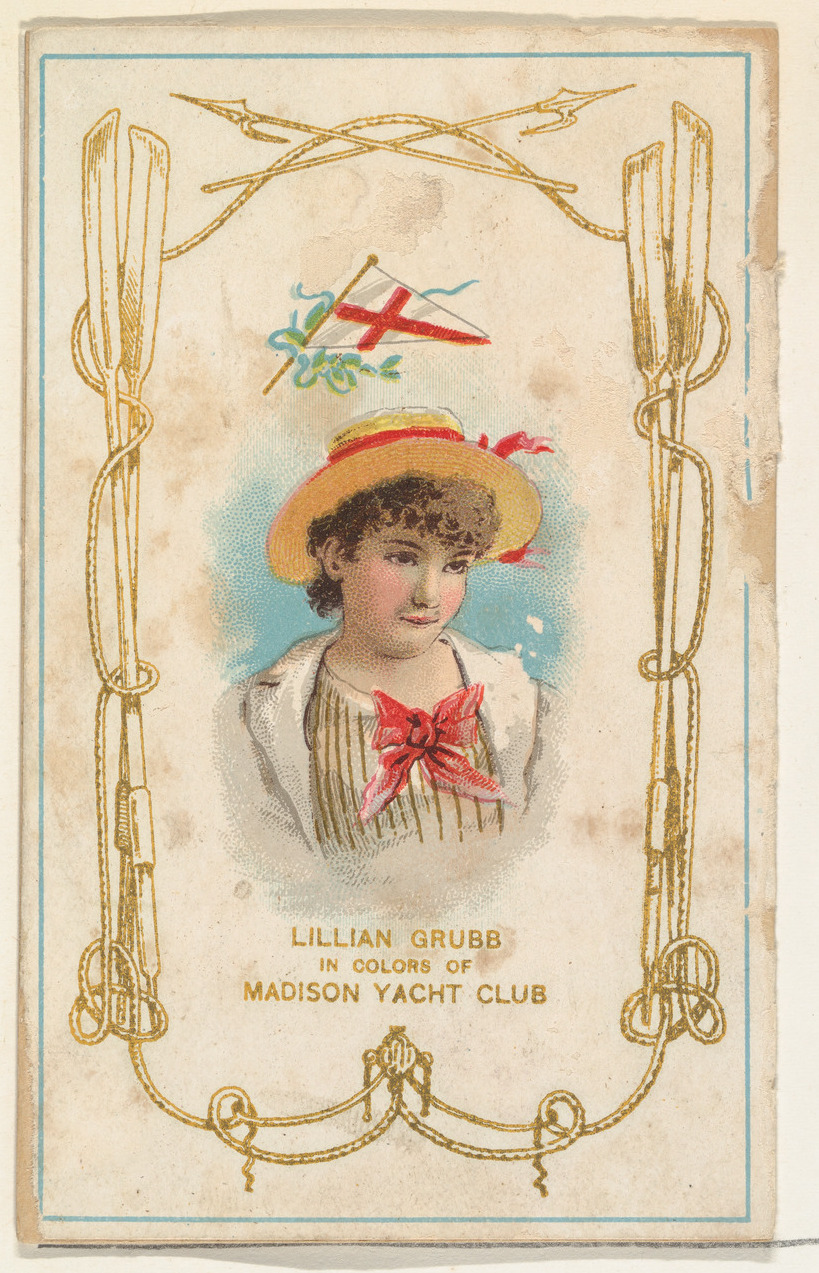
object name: print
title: Lillian Grubb in the Colors of the Madison Yacht Club, from the Yacht Colors of the World series (N140) issued by Duke Sons & Co. to promote Honest Long Cut Tobacco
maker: w. duke, sons & co.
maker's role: publisher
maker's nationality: american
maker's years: 1870-1920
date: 1890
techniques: color lithograph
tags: portraits,women,flags